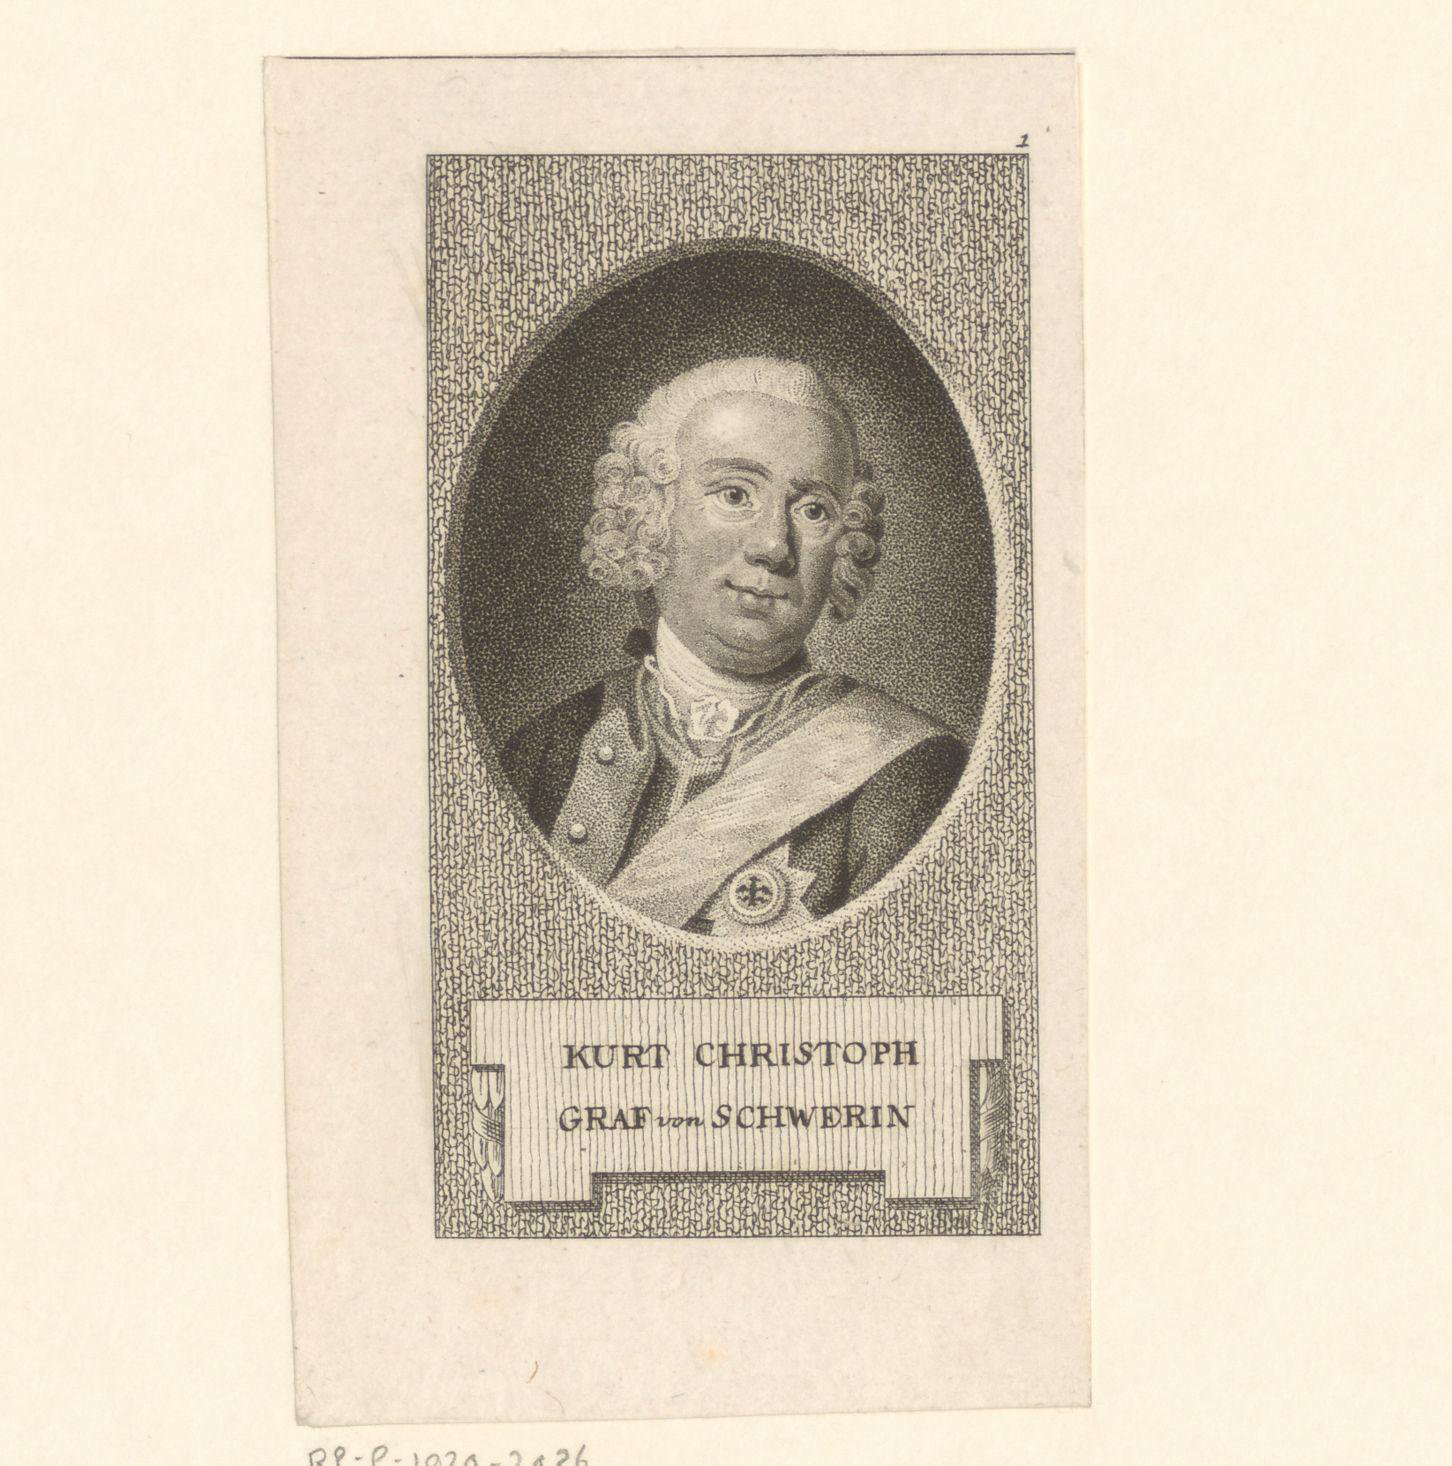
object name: print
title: Portret van Kurd Christoph von Schwerin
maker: daniel berger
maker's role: print maker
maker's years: 1744-1824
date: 1789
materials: paper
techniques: etching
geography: berlin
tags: prague, historical persons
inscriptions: collector's mark: Lugt 2228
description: Prent ook gebruikt in: Militairisch-genealogischer Calender auf das Jahr 1790, uitgegeven in Berlijn.